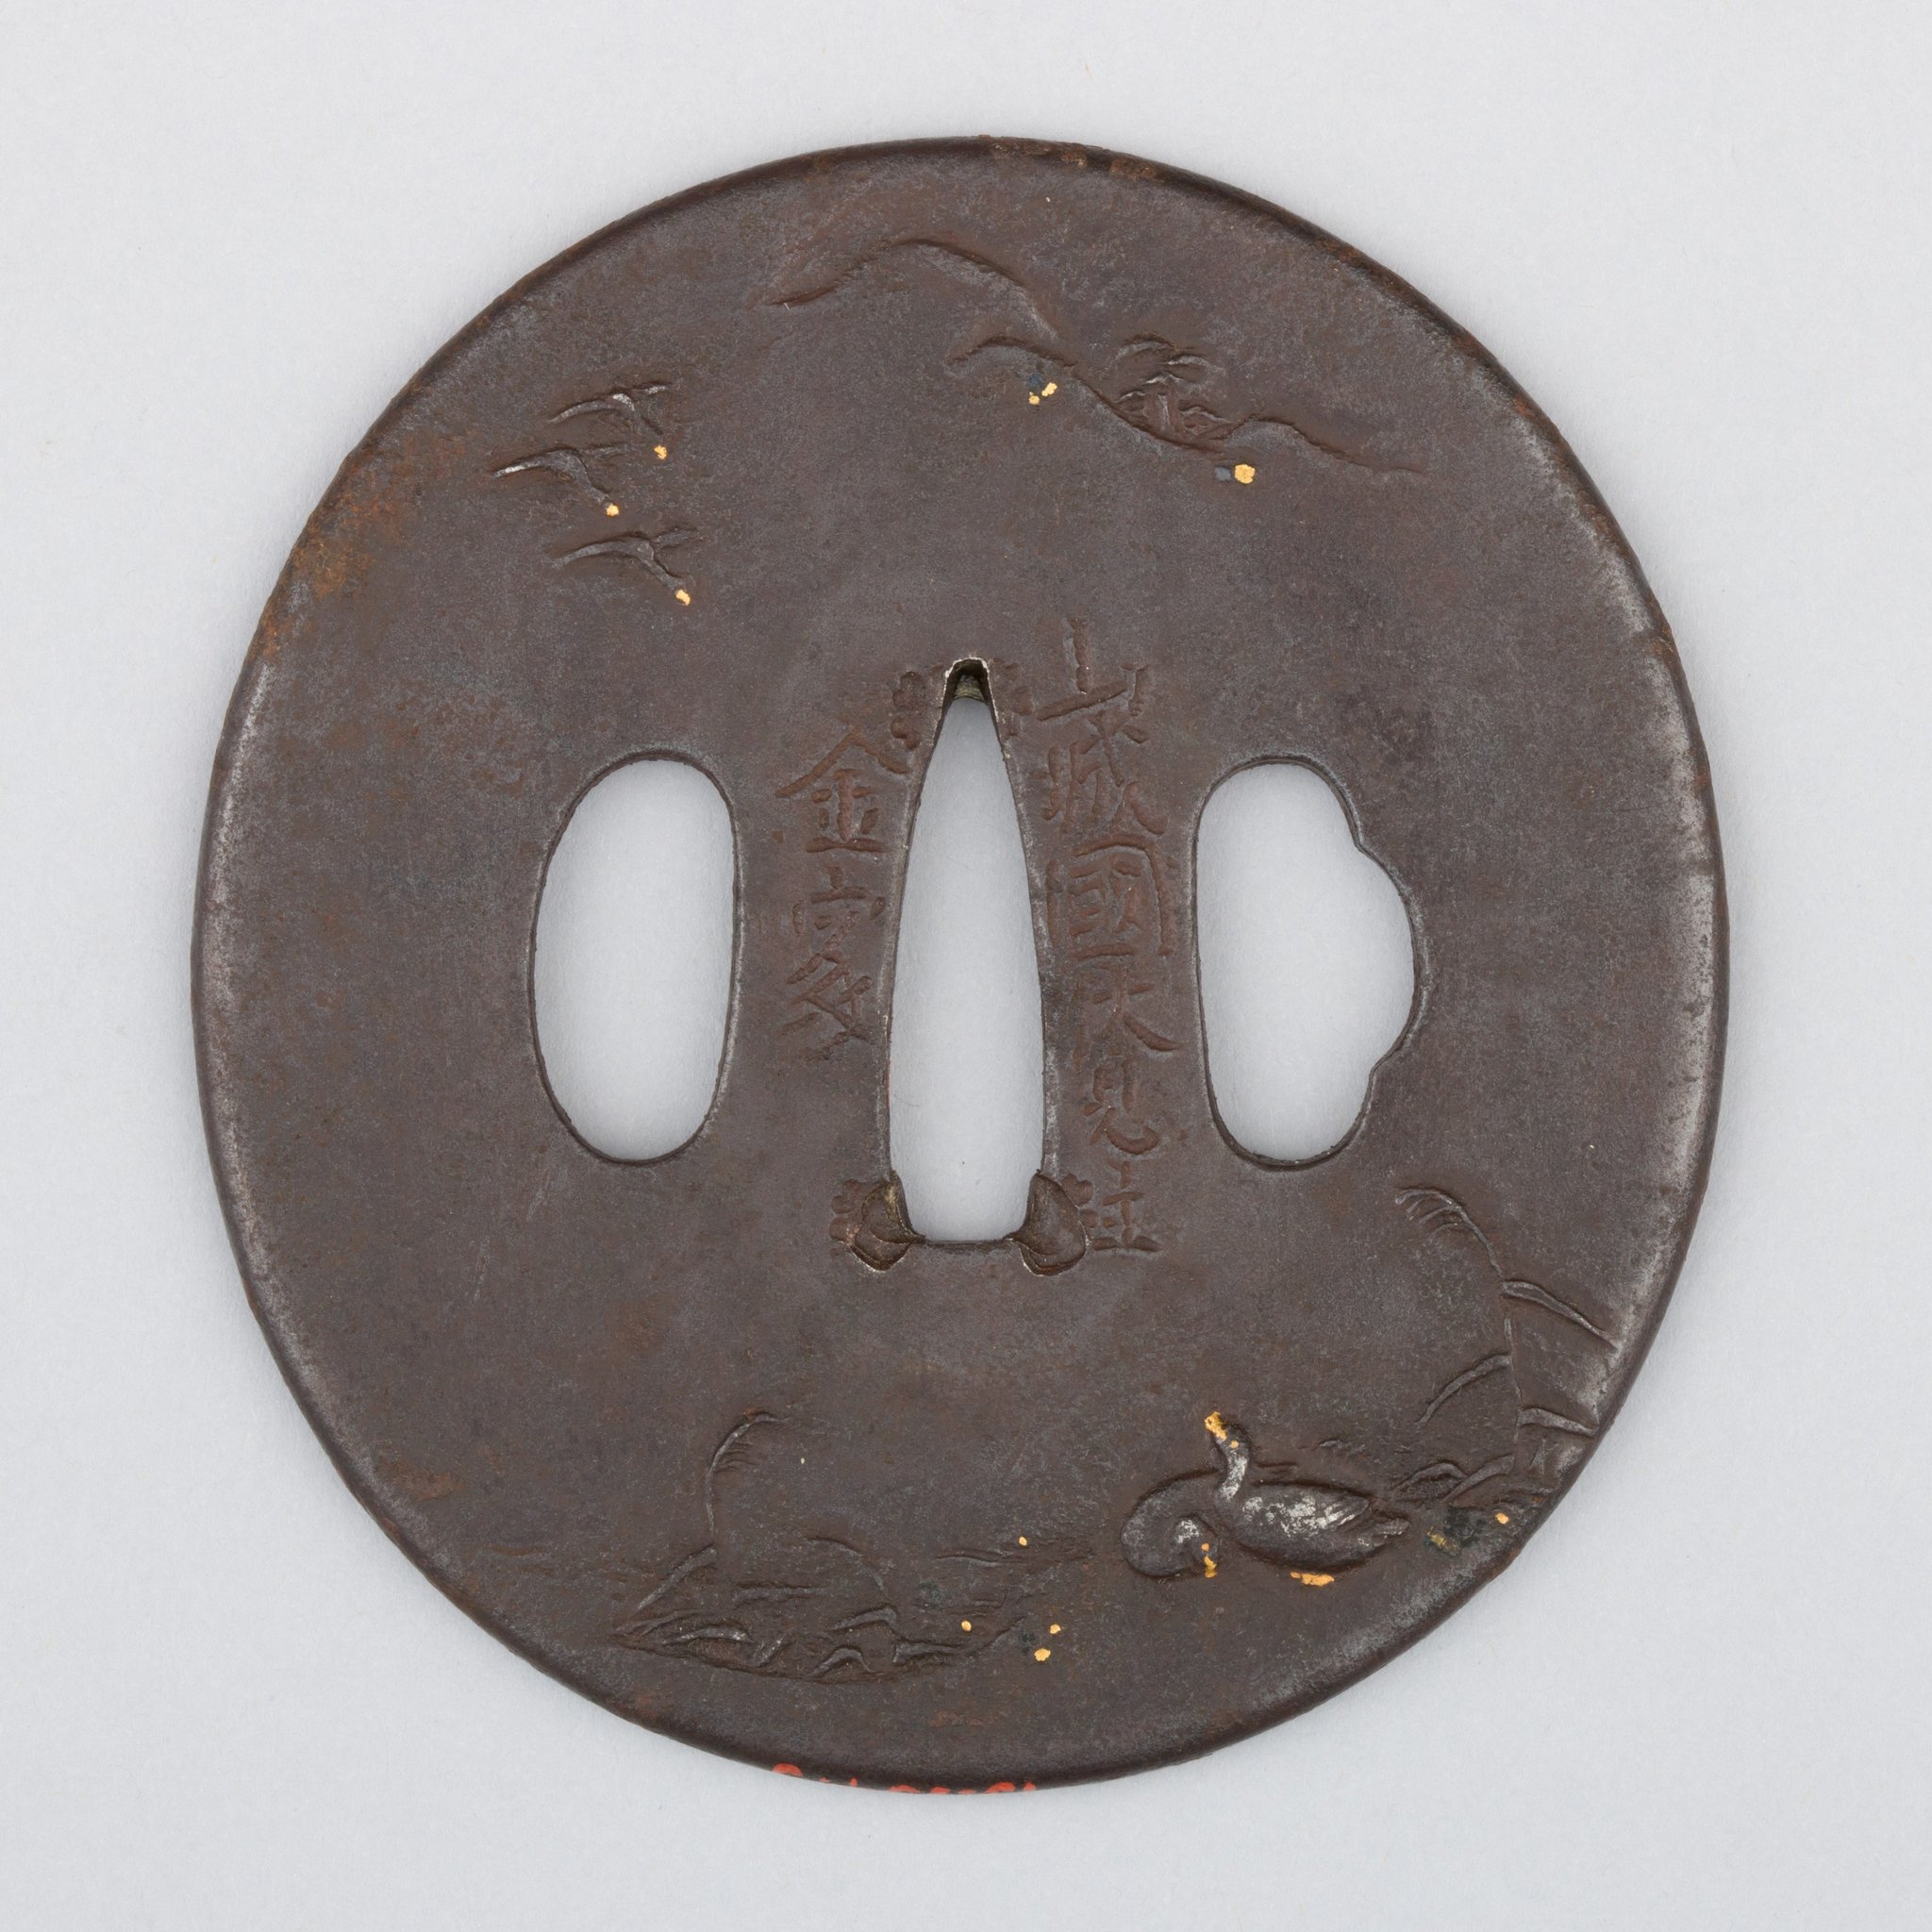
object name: sword guard tsuba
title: Sword Guard (Tsuba)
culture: japanese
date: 1615-1868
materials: gold, iron, silver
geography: japan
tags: geese